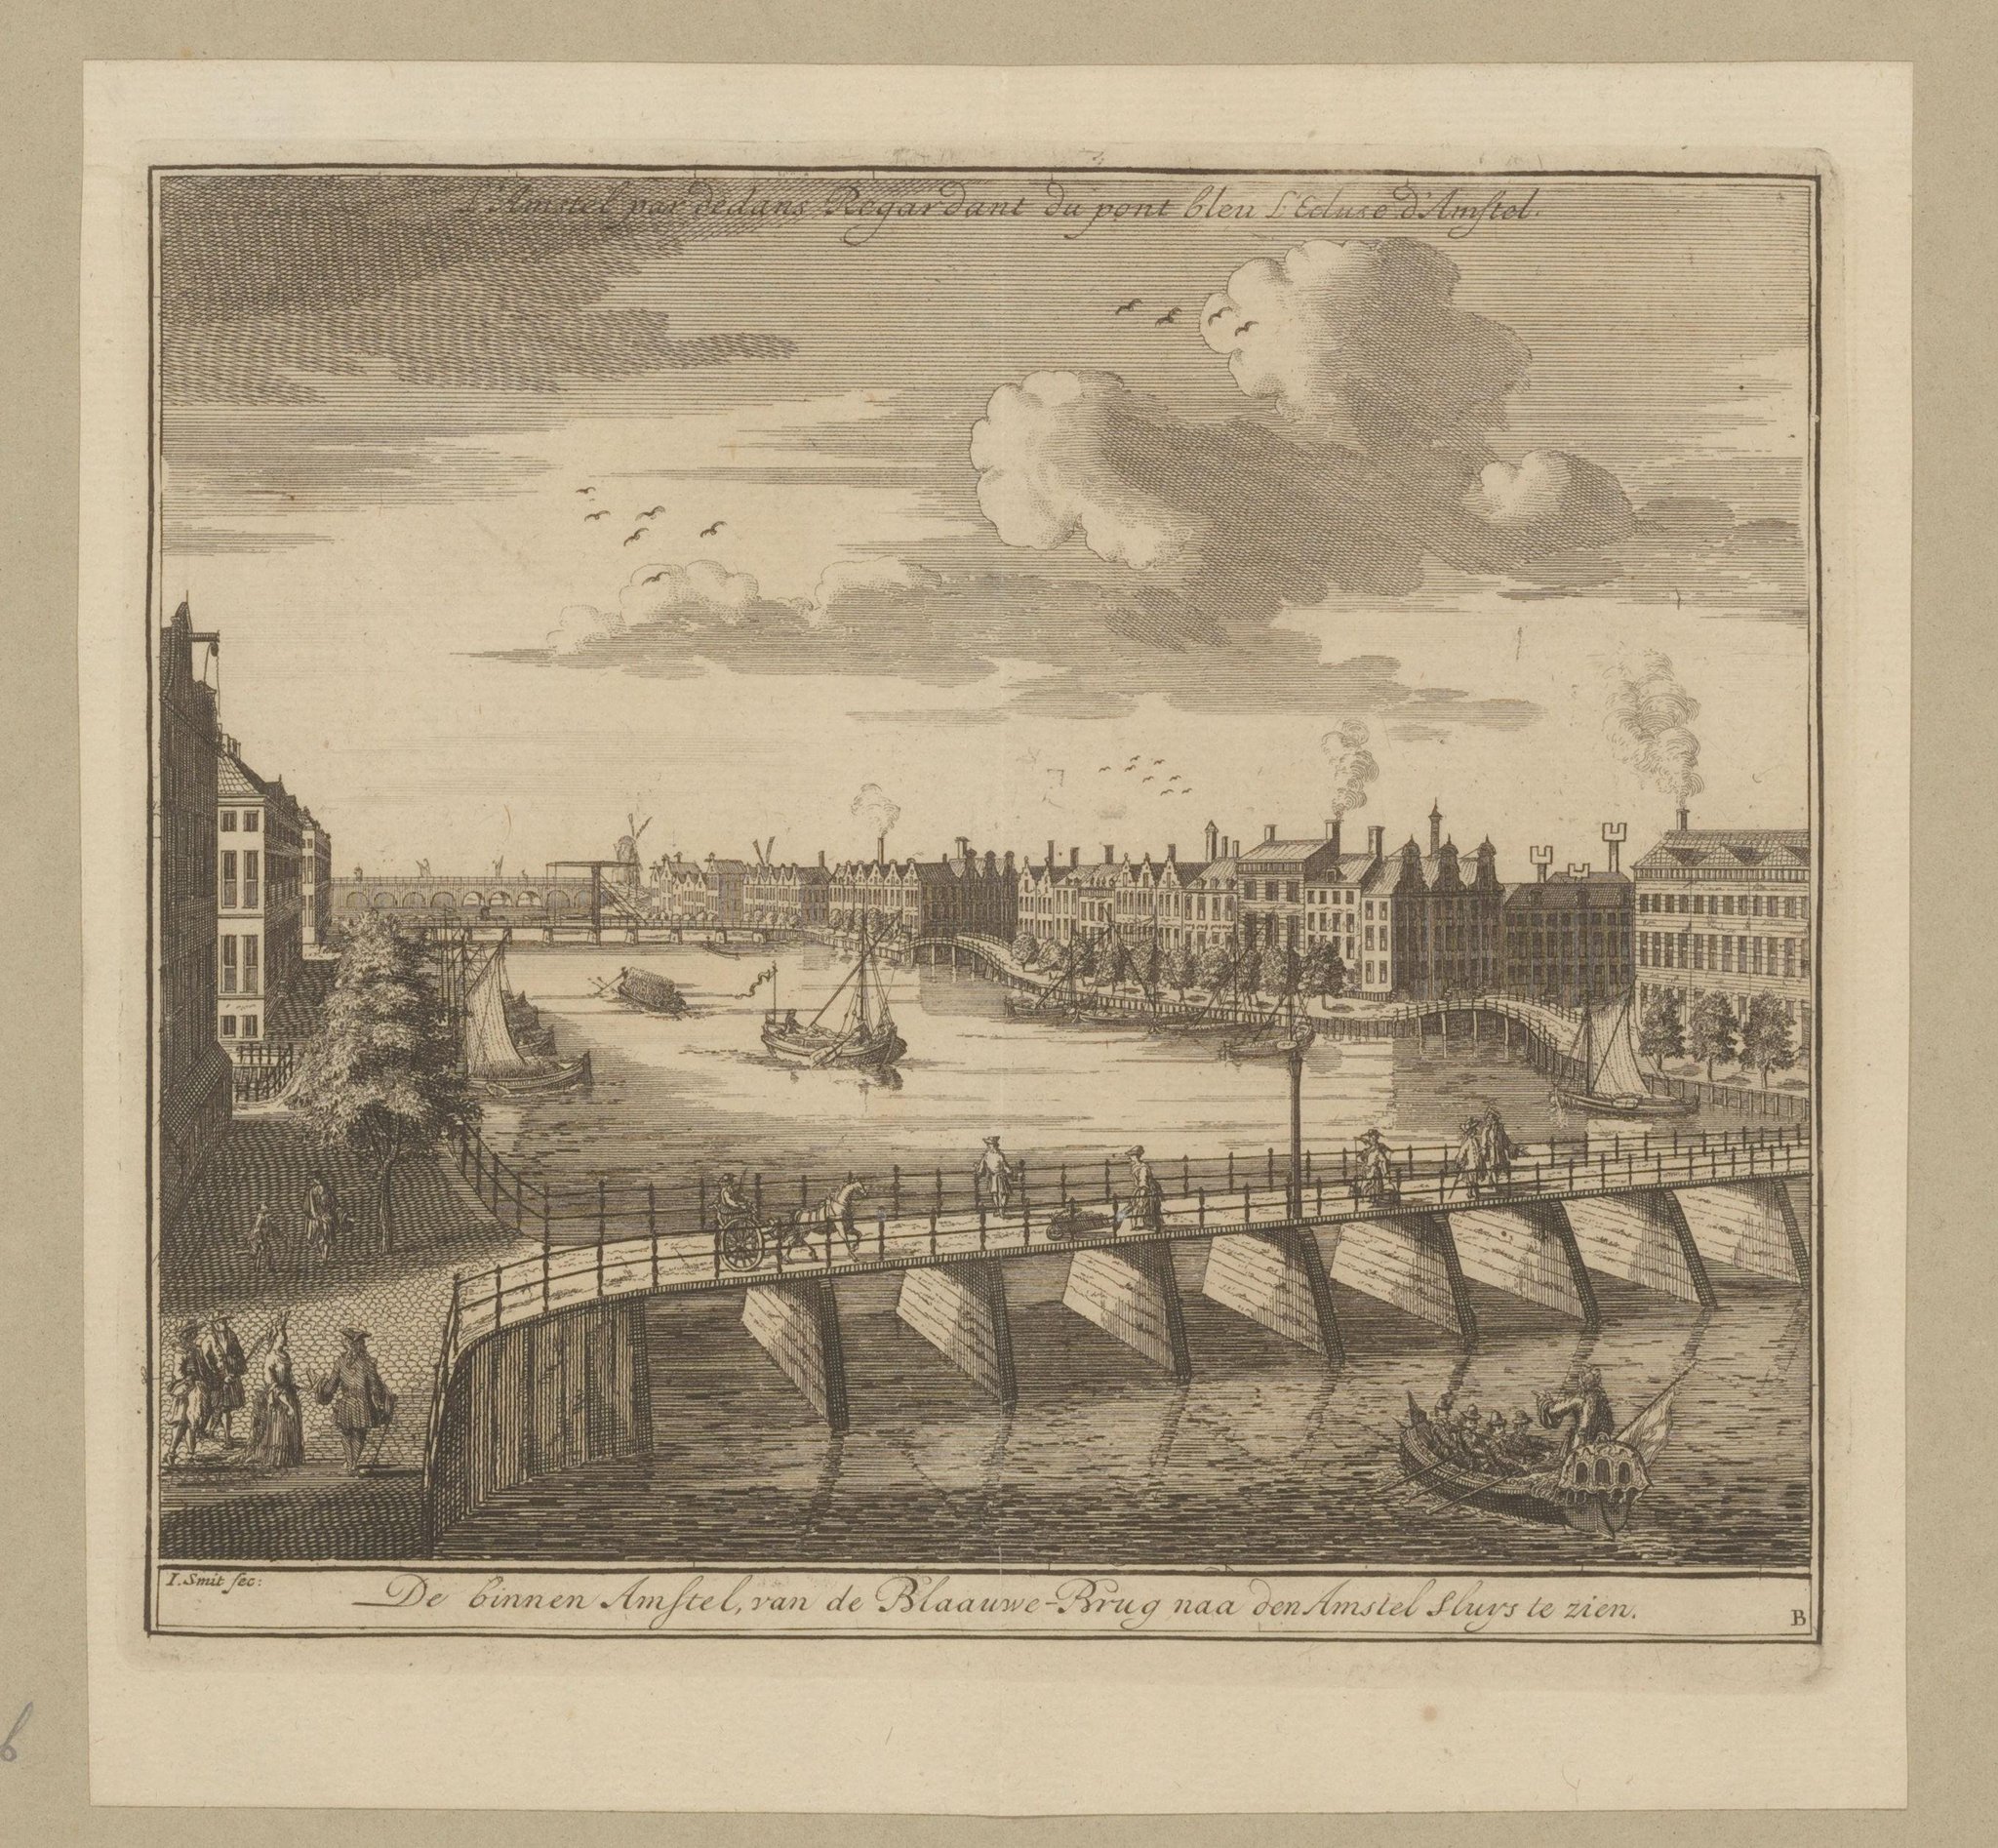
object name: print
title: De binnen Amstel, van de Blaauwe-brug naa den Amstel sluys te zien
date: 1700-1748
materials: paper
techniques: etching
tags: city-view in general; 'veduta', canal, ships (in general) - cc - more than one ship, bridge in city across river, canal, etc., boat propelled by man or animal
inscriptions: collector's mark: ‘4B 53a n b’ Lugt 1641b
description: Onderwerpsrubriek binnen de Atlas Amsterdam: Amstel van Blauwbrug tot Hogesluis. Rechtsonder: B.